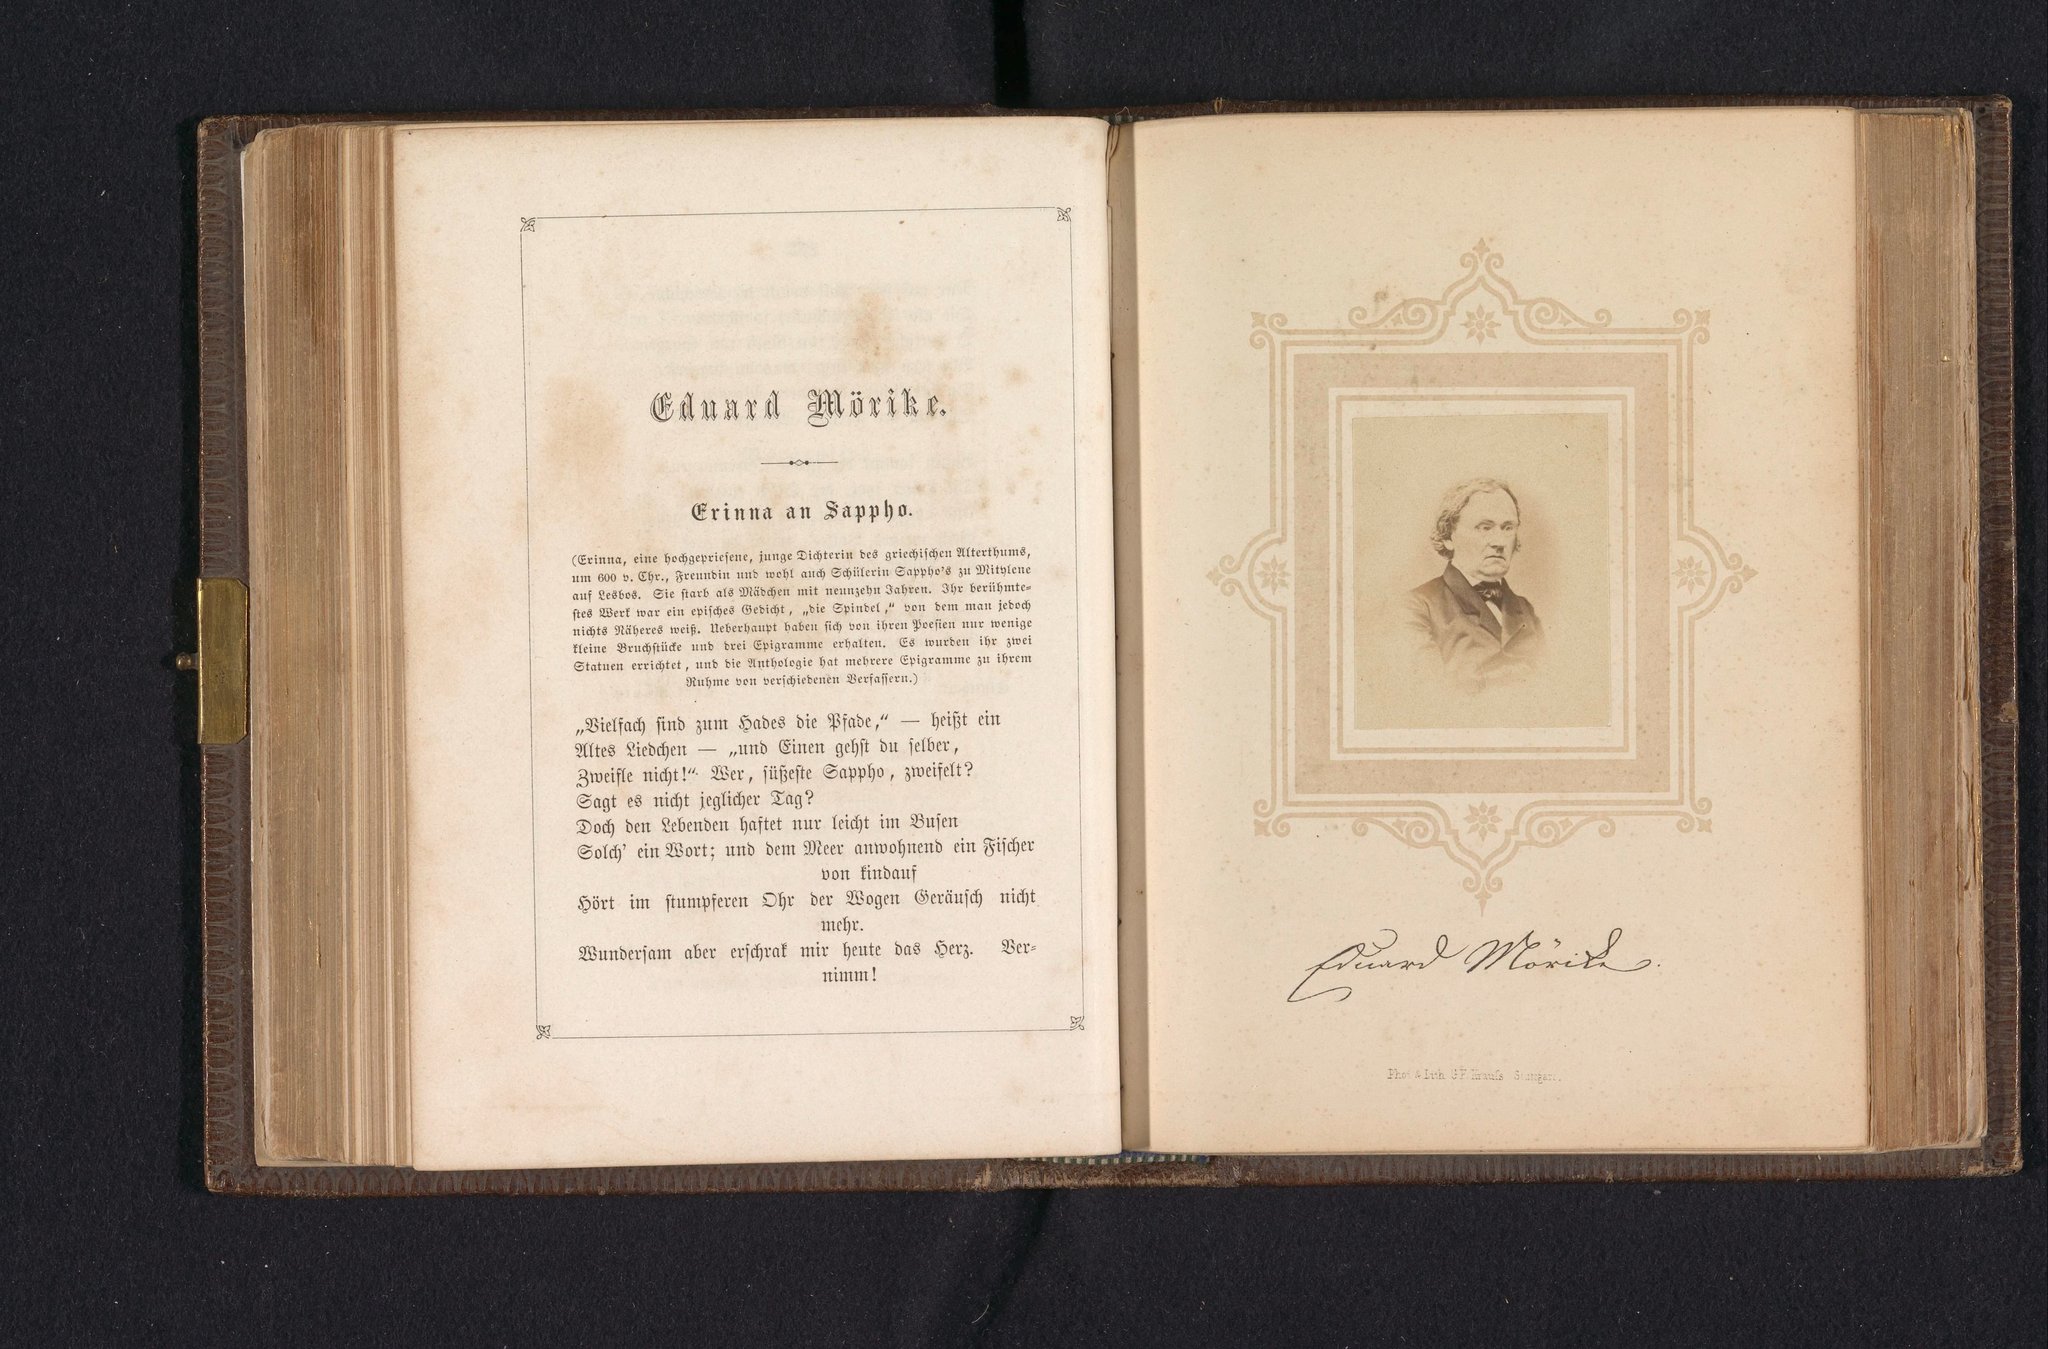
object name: page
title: Portret van Eduard Mörike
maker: g.f. krauss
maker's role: fotograaf, lithograaf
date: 1854-1864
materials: photographic support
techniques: albumen print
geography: germany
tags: writer, poet, author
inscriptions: name